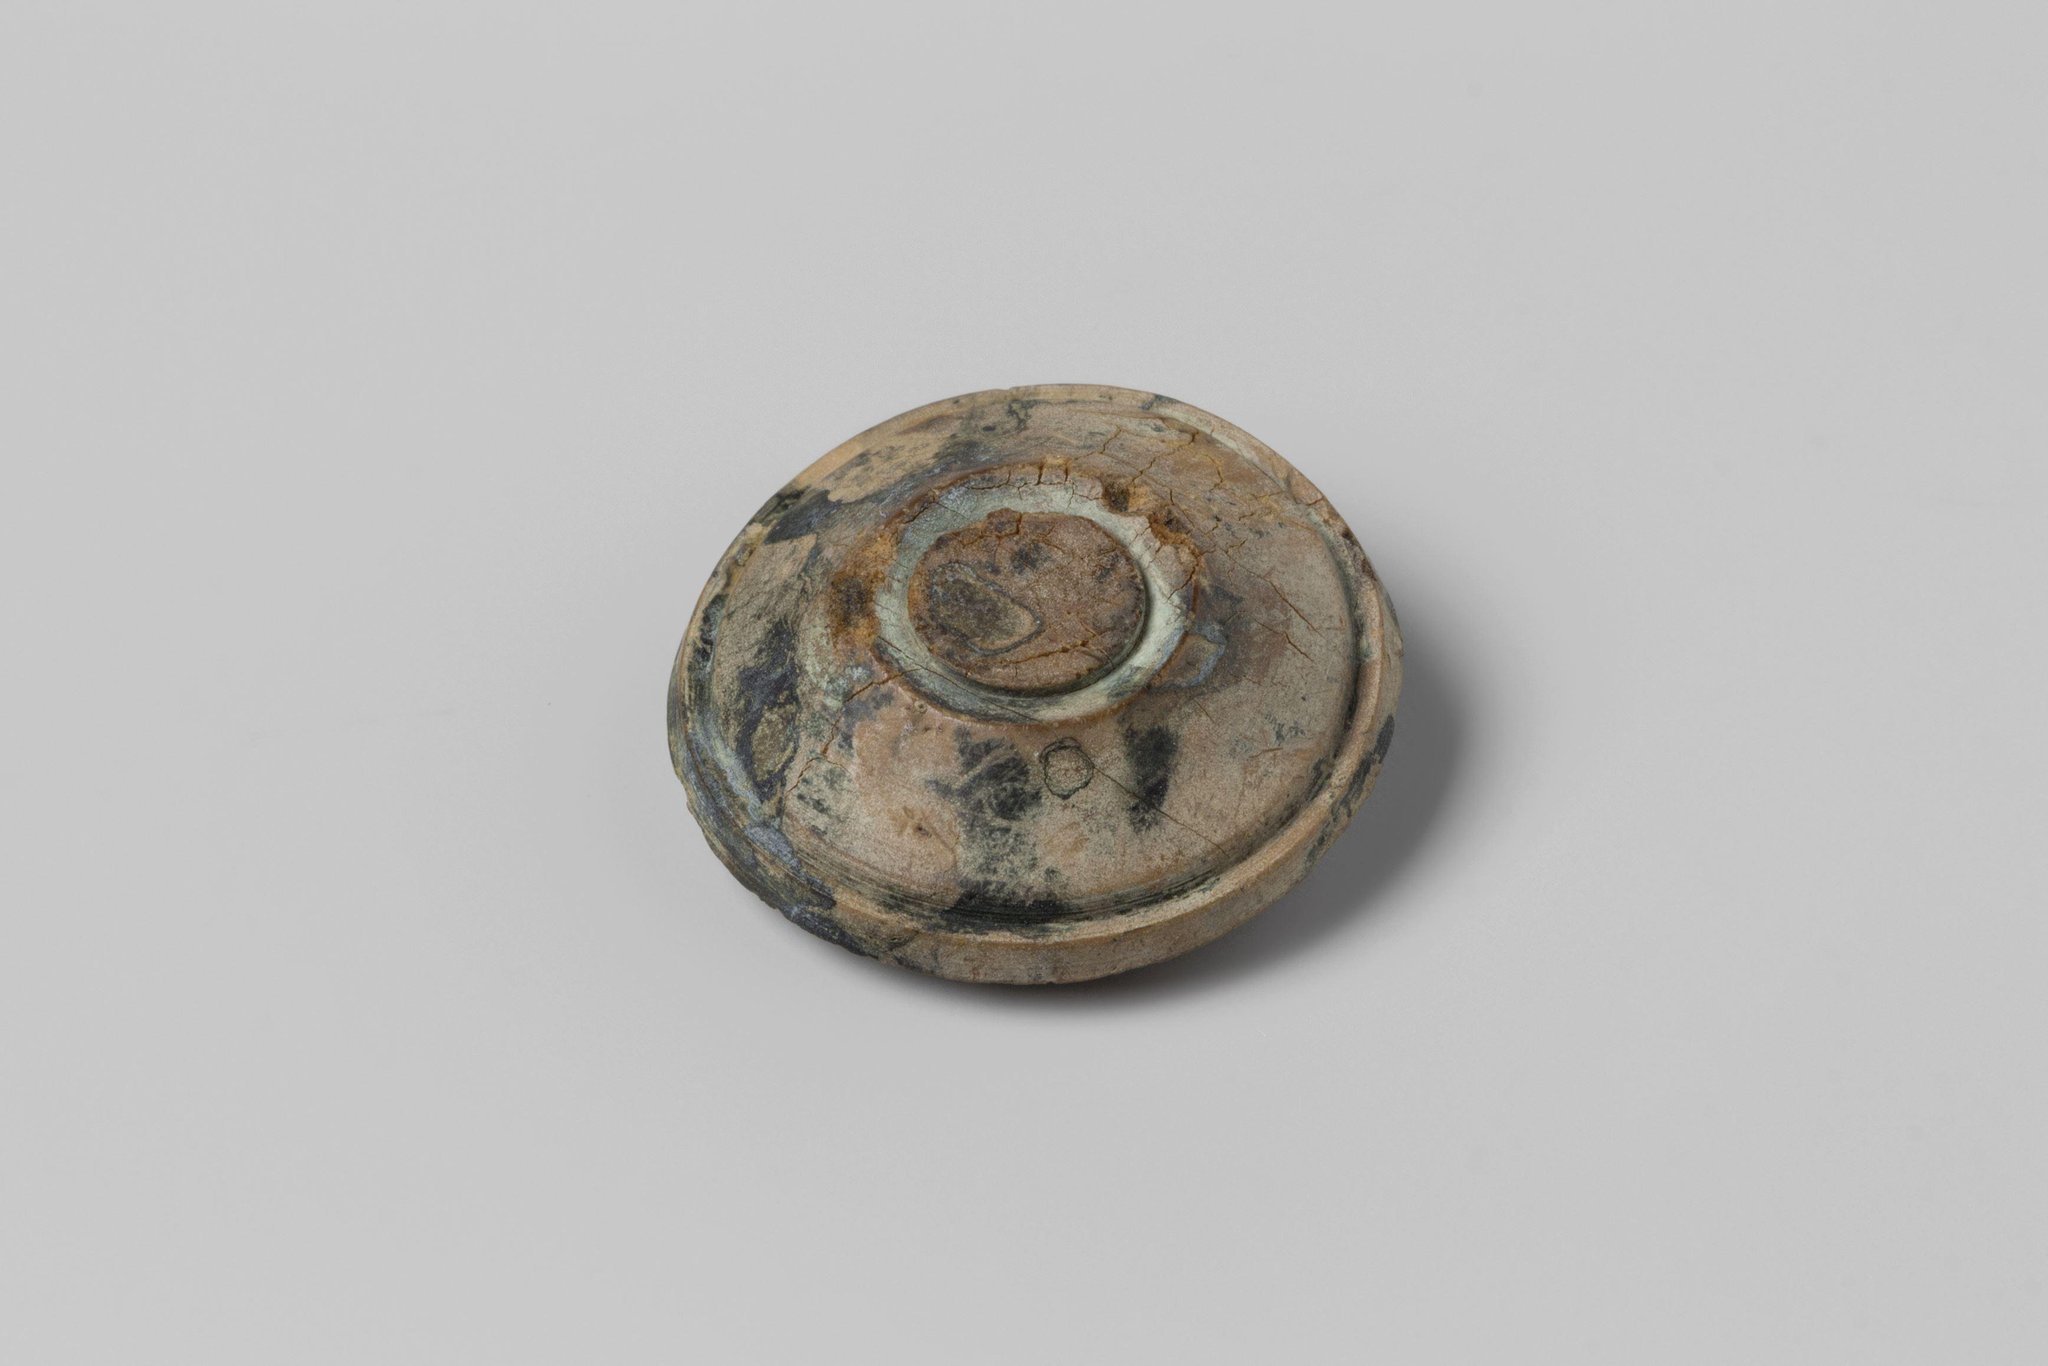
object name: button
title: Knoop uit het wrak van de Oost-Indiëvaarder Hollandia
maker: Anonymous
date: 1700-1743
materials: bone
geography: netherlands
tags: verenigde oostindische compagnie, hollandia (schip), annet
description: Knoop. (1) domed, concentric moulding (2.4d, 0.5t), flat central boss on top